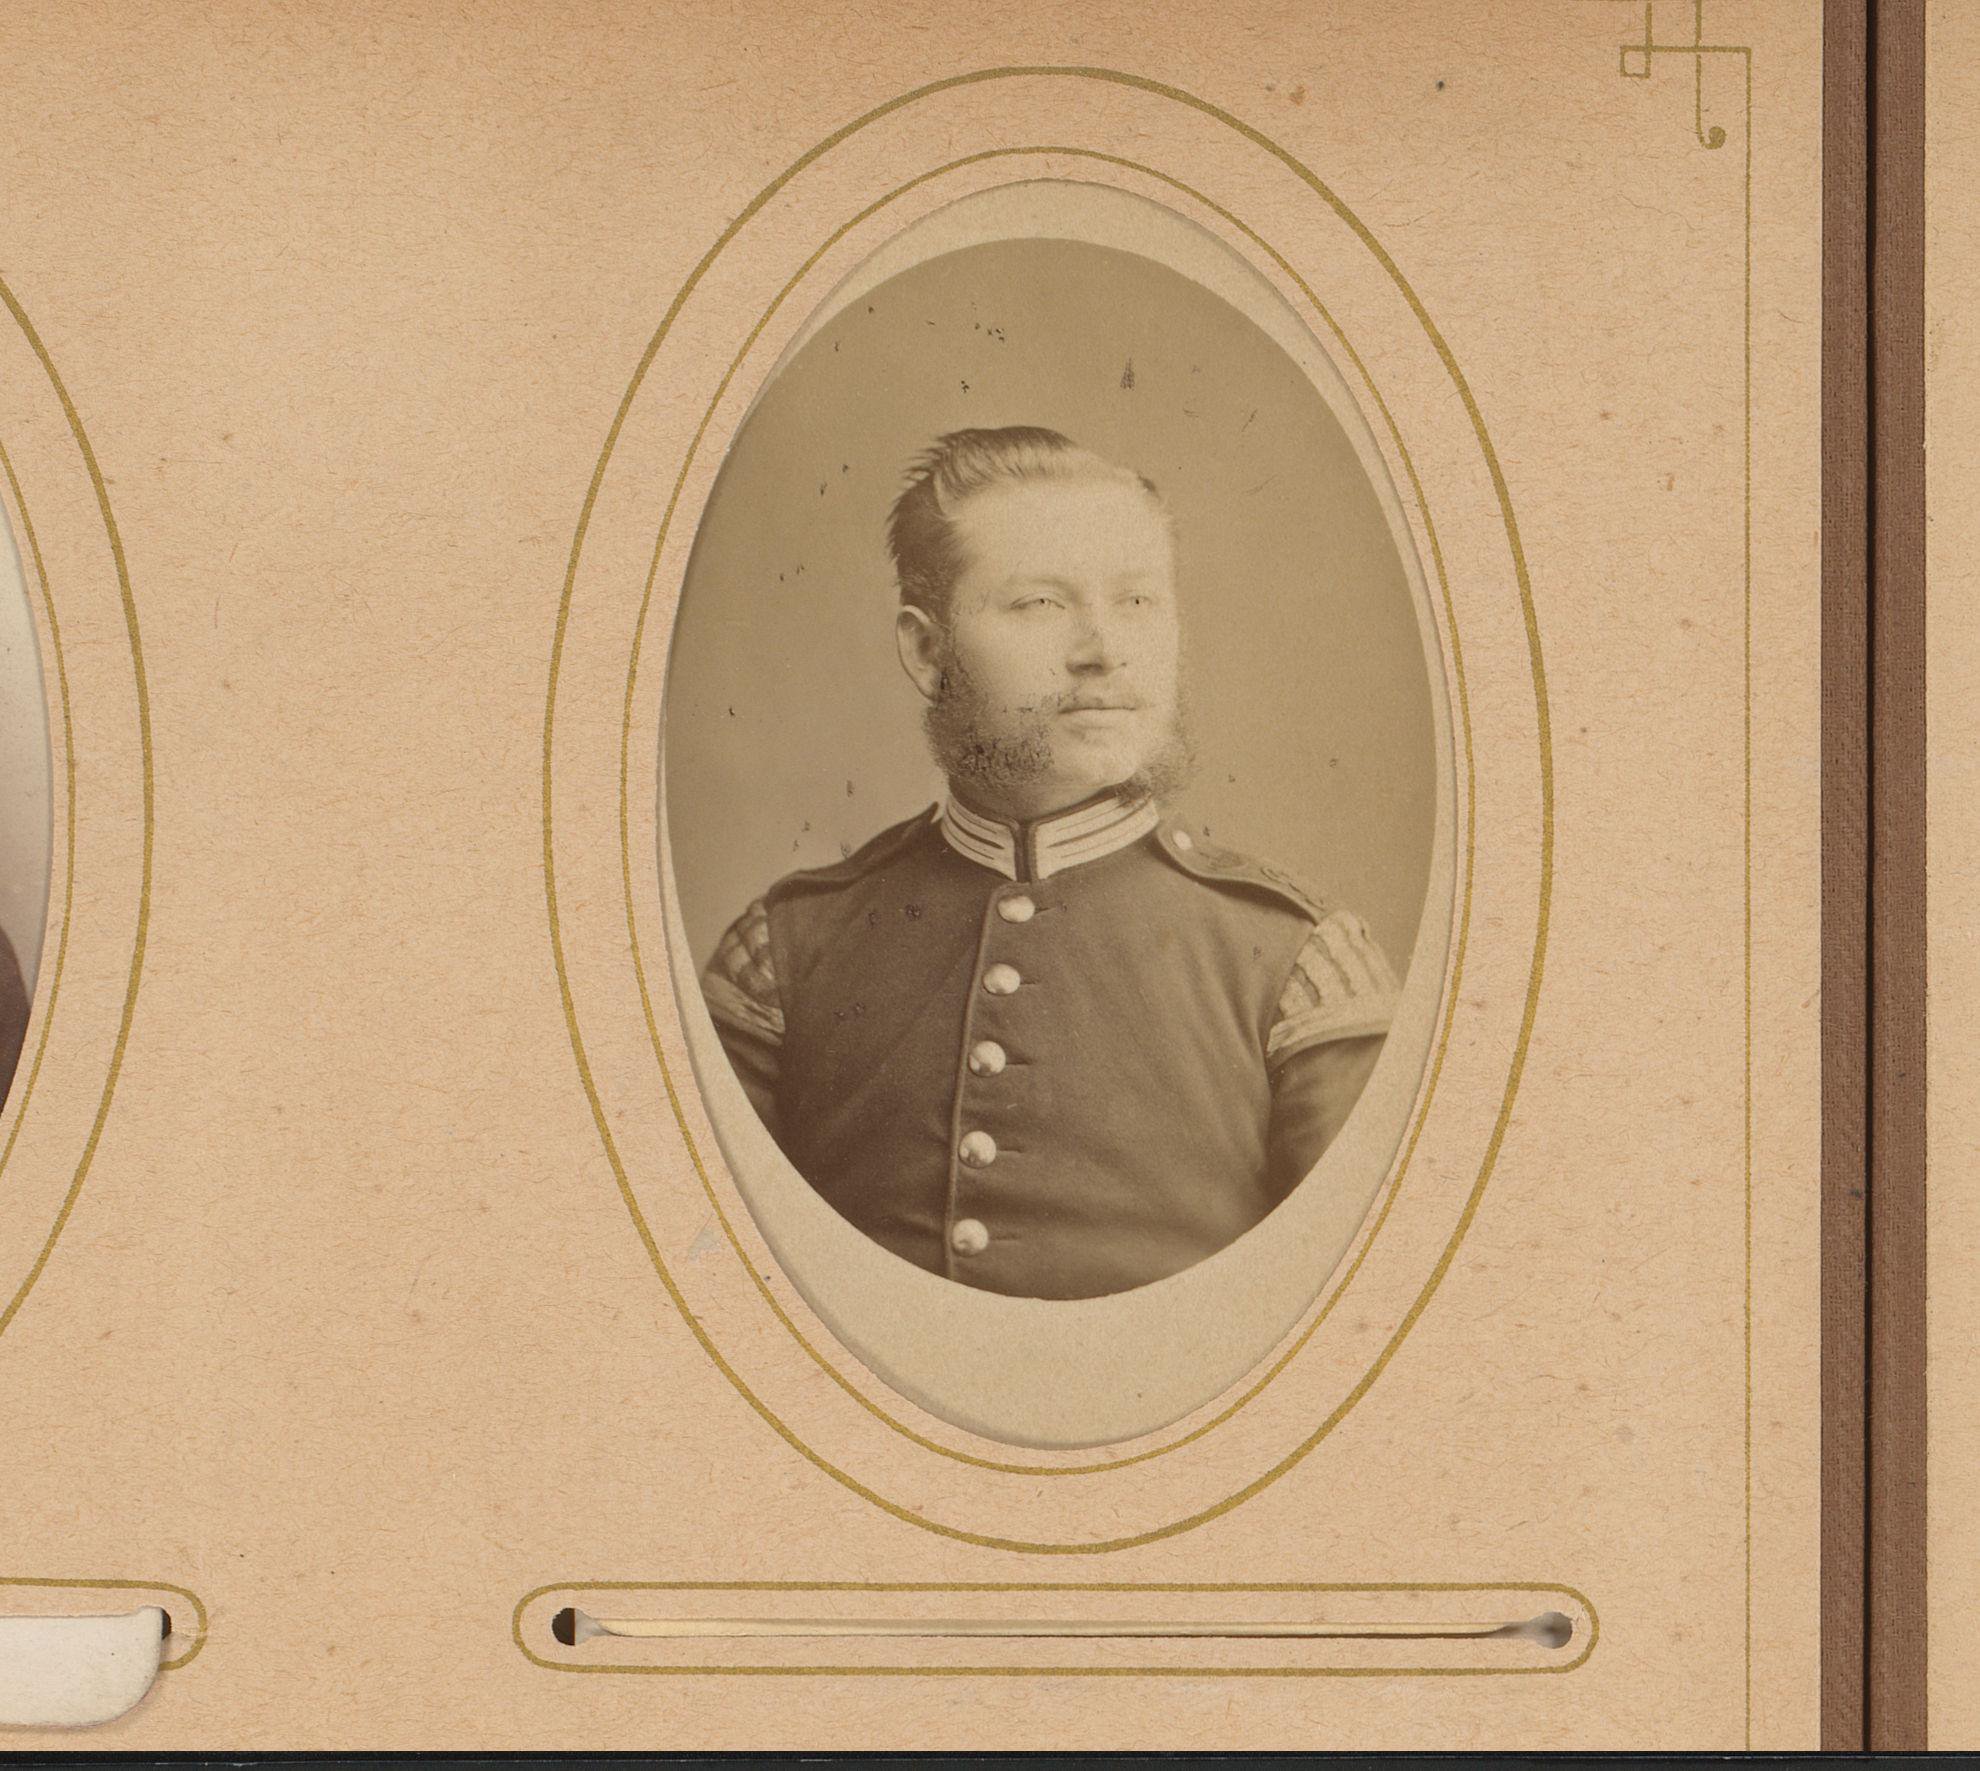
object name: carte de visite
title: Portret van een man in uniform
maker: franz ehrlich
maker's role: fotograaf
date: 1860-1900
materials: cardboard, photographic support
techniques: albumen print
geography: dresden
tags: sideburns, historical persons, (military) uniforms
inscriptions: inscription: ‘Photographie/ von/ FRANZ EHRLICH/ Georgplatz 12/ Dresden/ Zu Nachbestellungen wird die Platte aufbewahrt.’